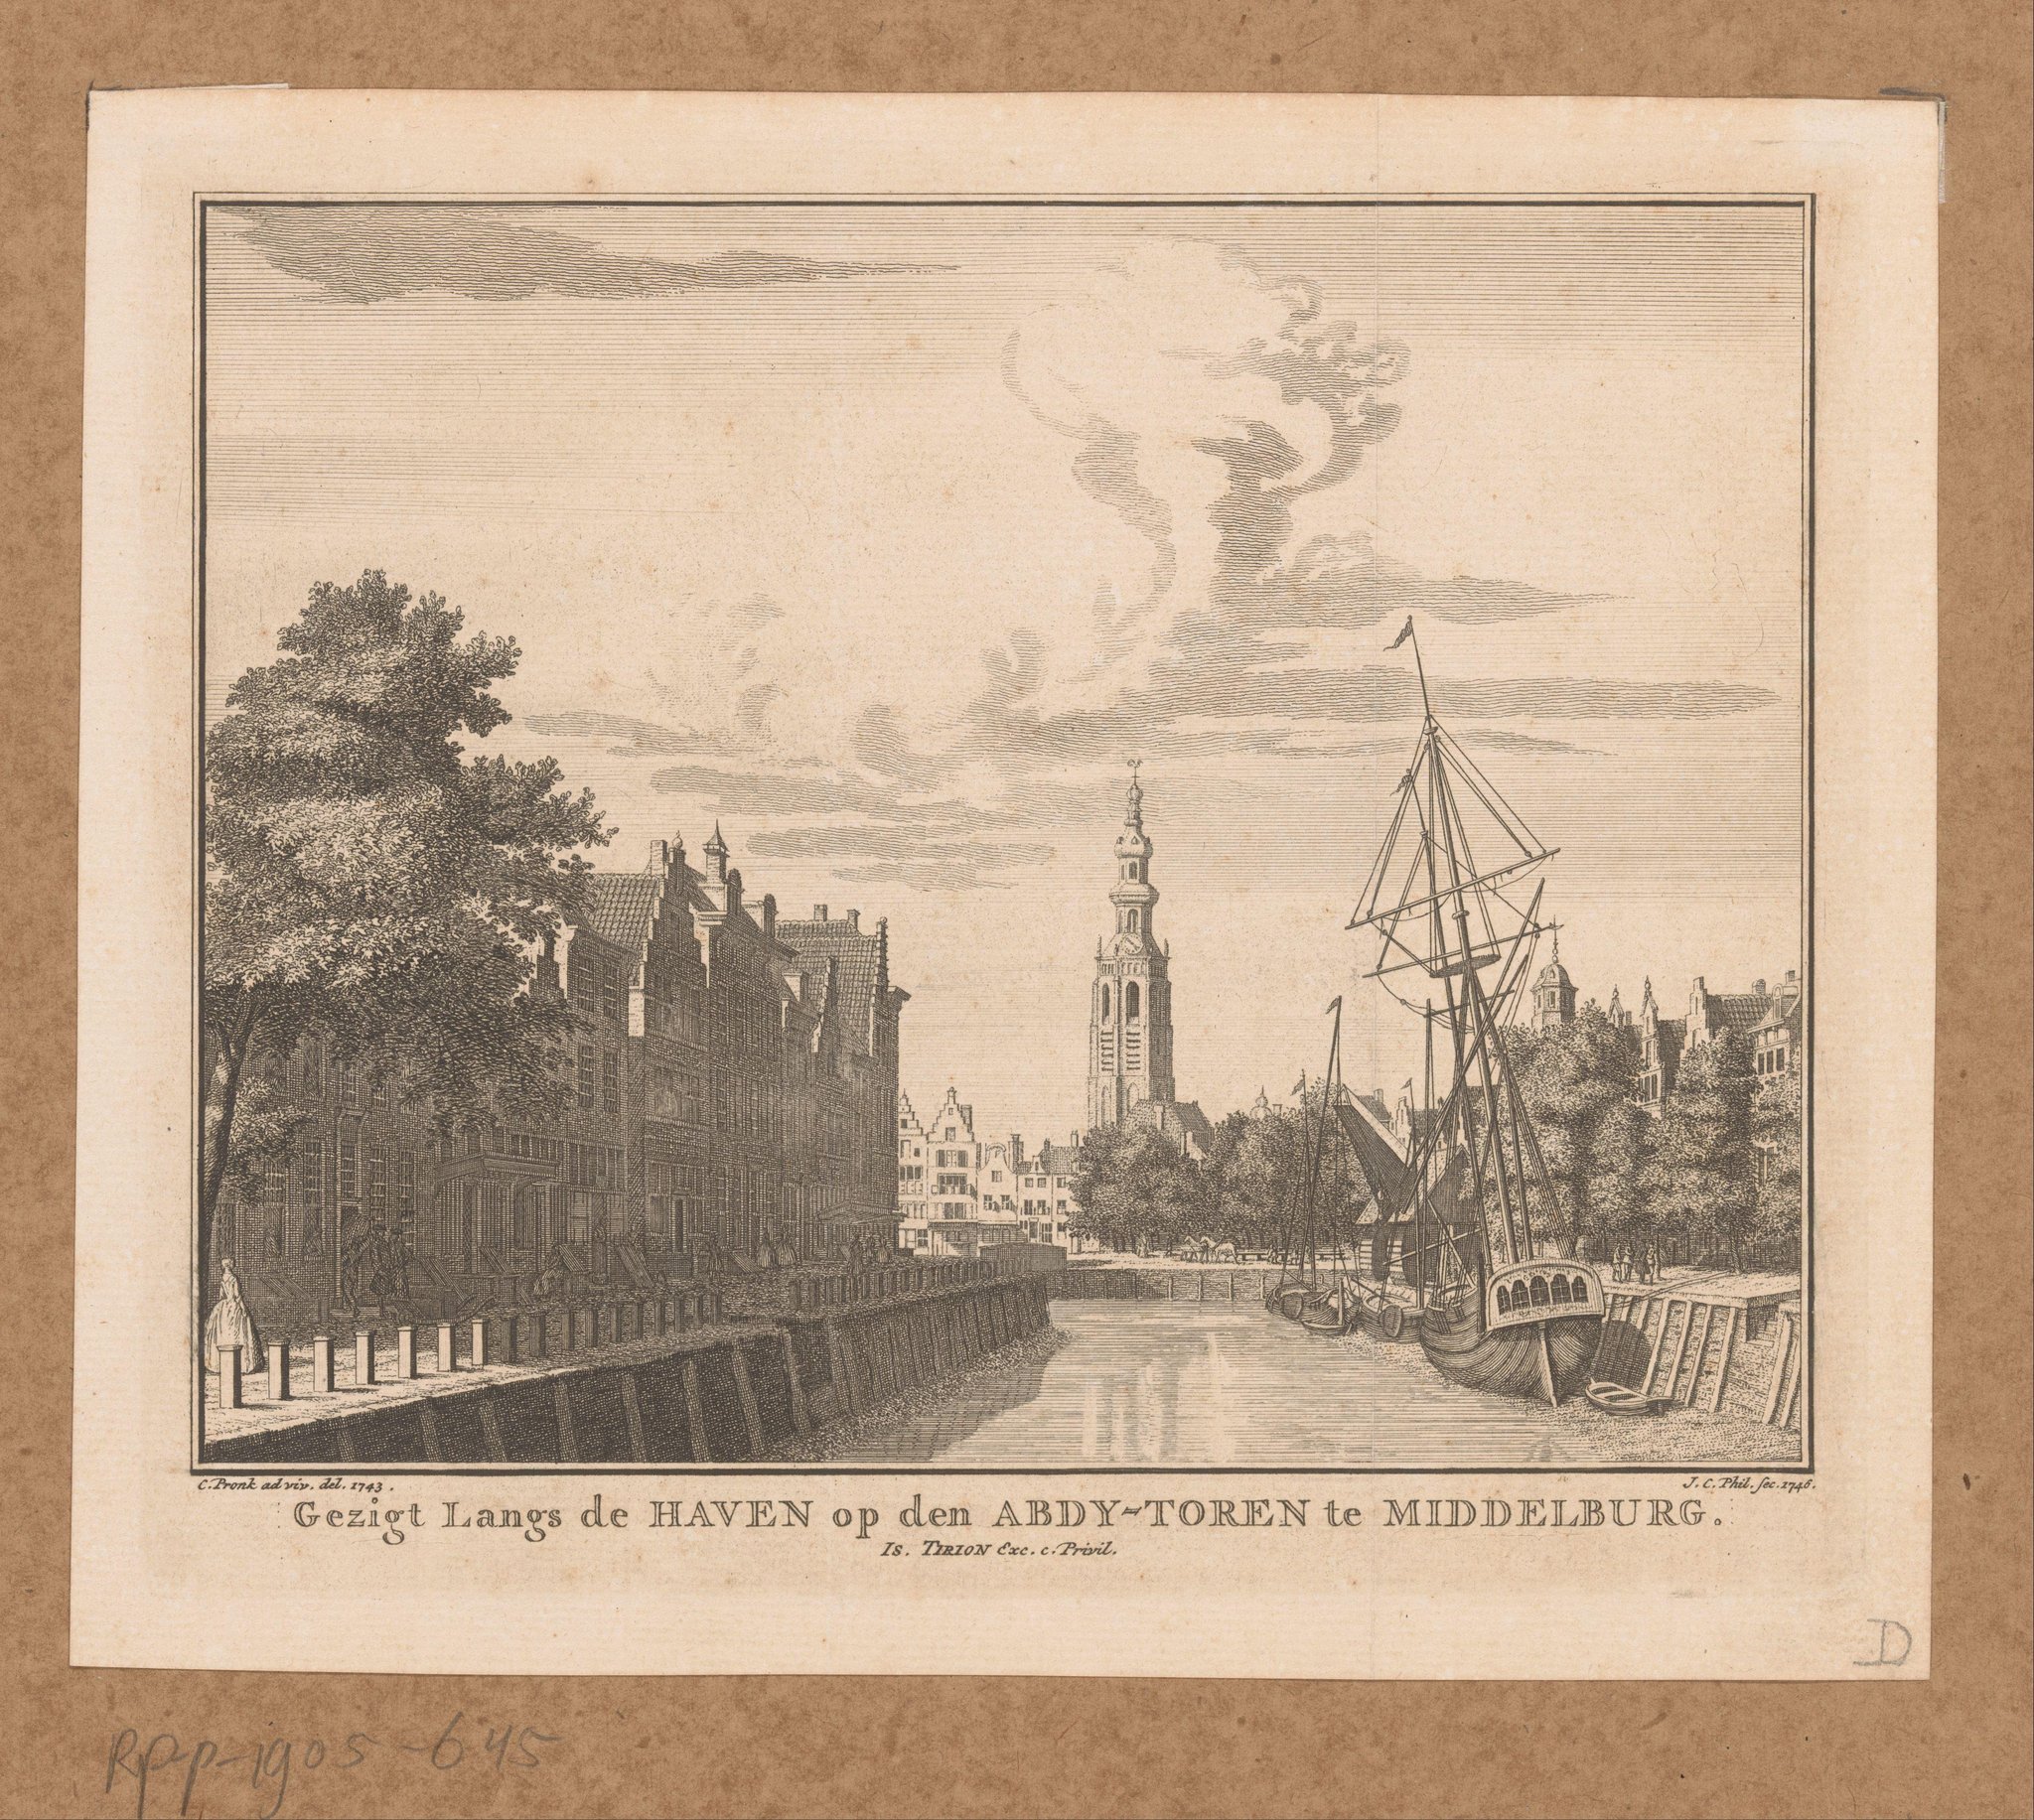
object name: print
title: Gezicht op de Lange Jan (Abdijtoren) te Middelburg, 1743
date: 1746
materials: paper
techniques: etching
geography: amsterdam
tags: harbour, church (exterior), prospect of city, town panorama, silhouette of city, middelburg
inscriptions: collector's mark: Lugt 2228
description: Prent ook gebruikt in: Boddaert, Pieter et al. Tegenwoordige staat der Vereenigde Nederlanden (...). Amsterdam: Isaak Tirion, 1751, dl. 9. Zie RP-P-AO-15-161-5 voor proefdruk.